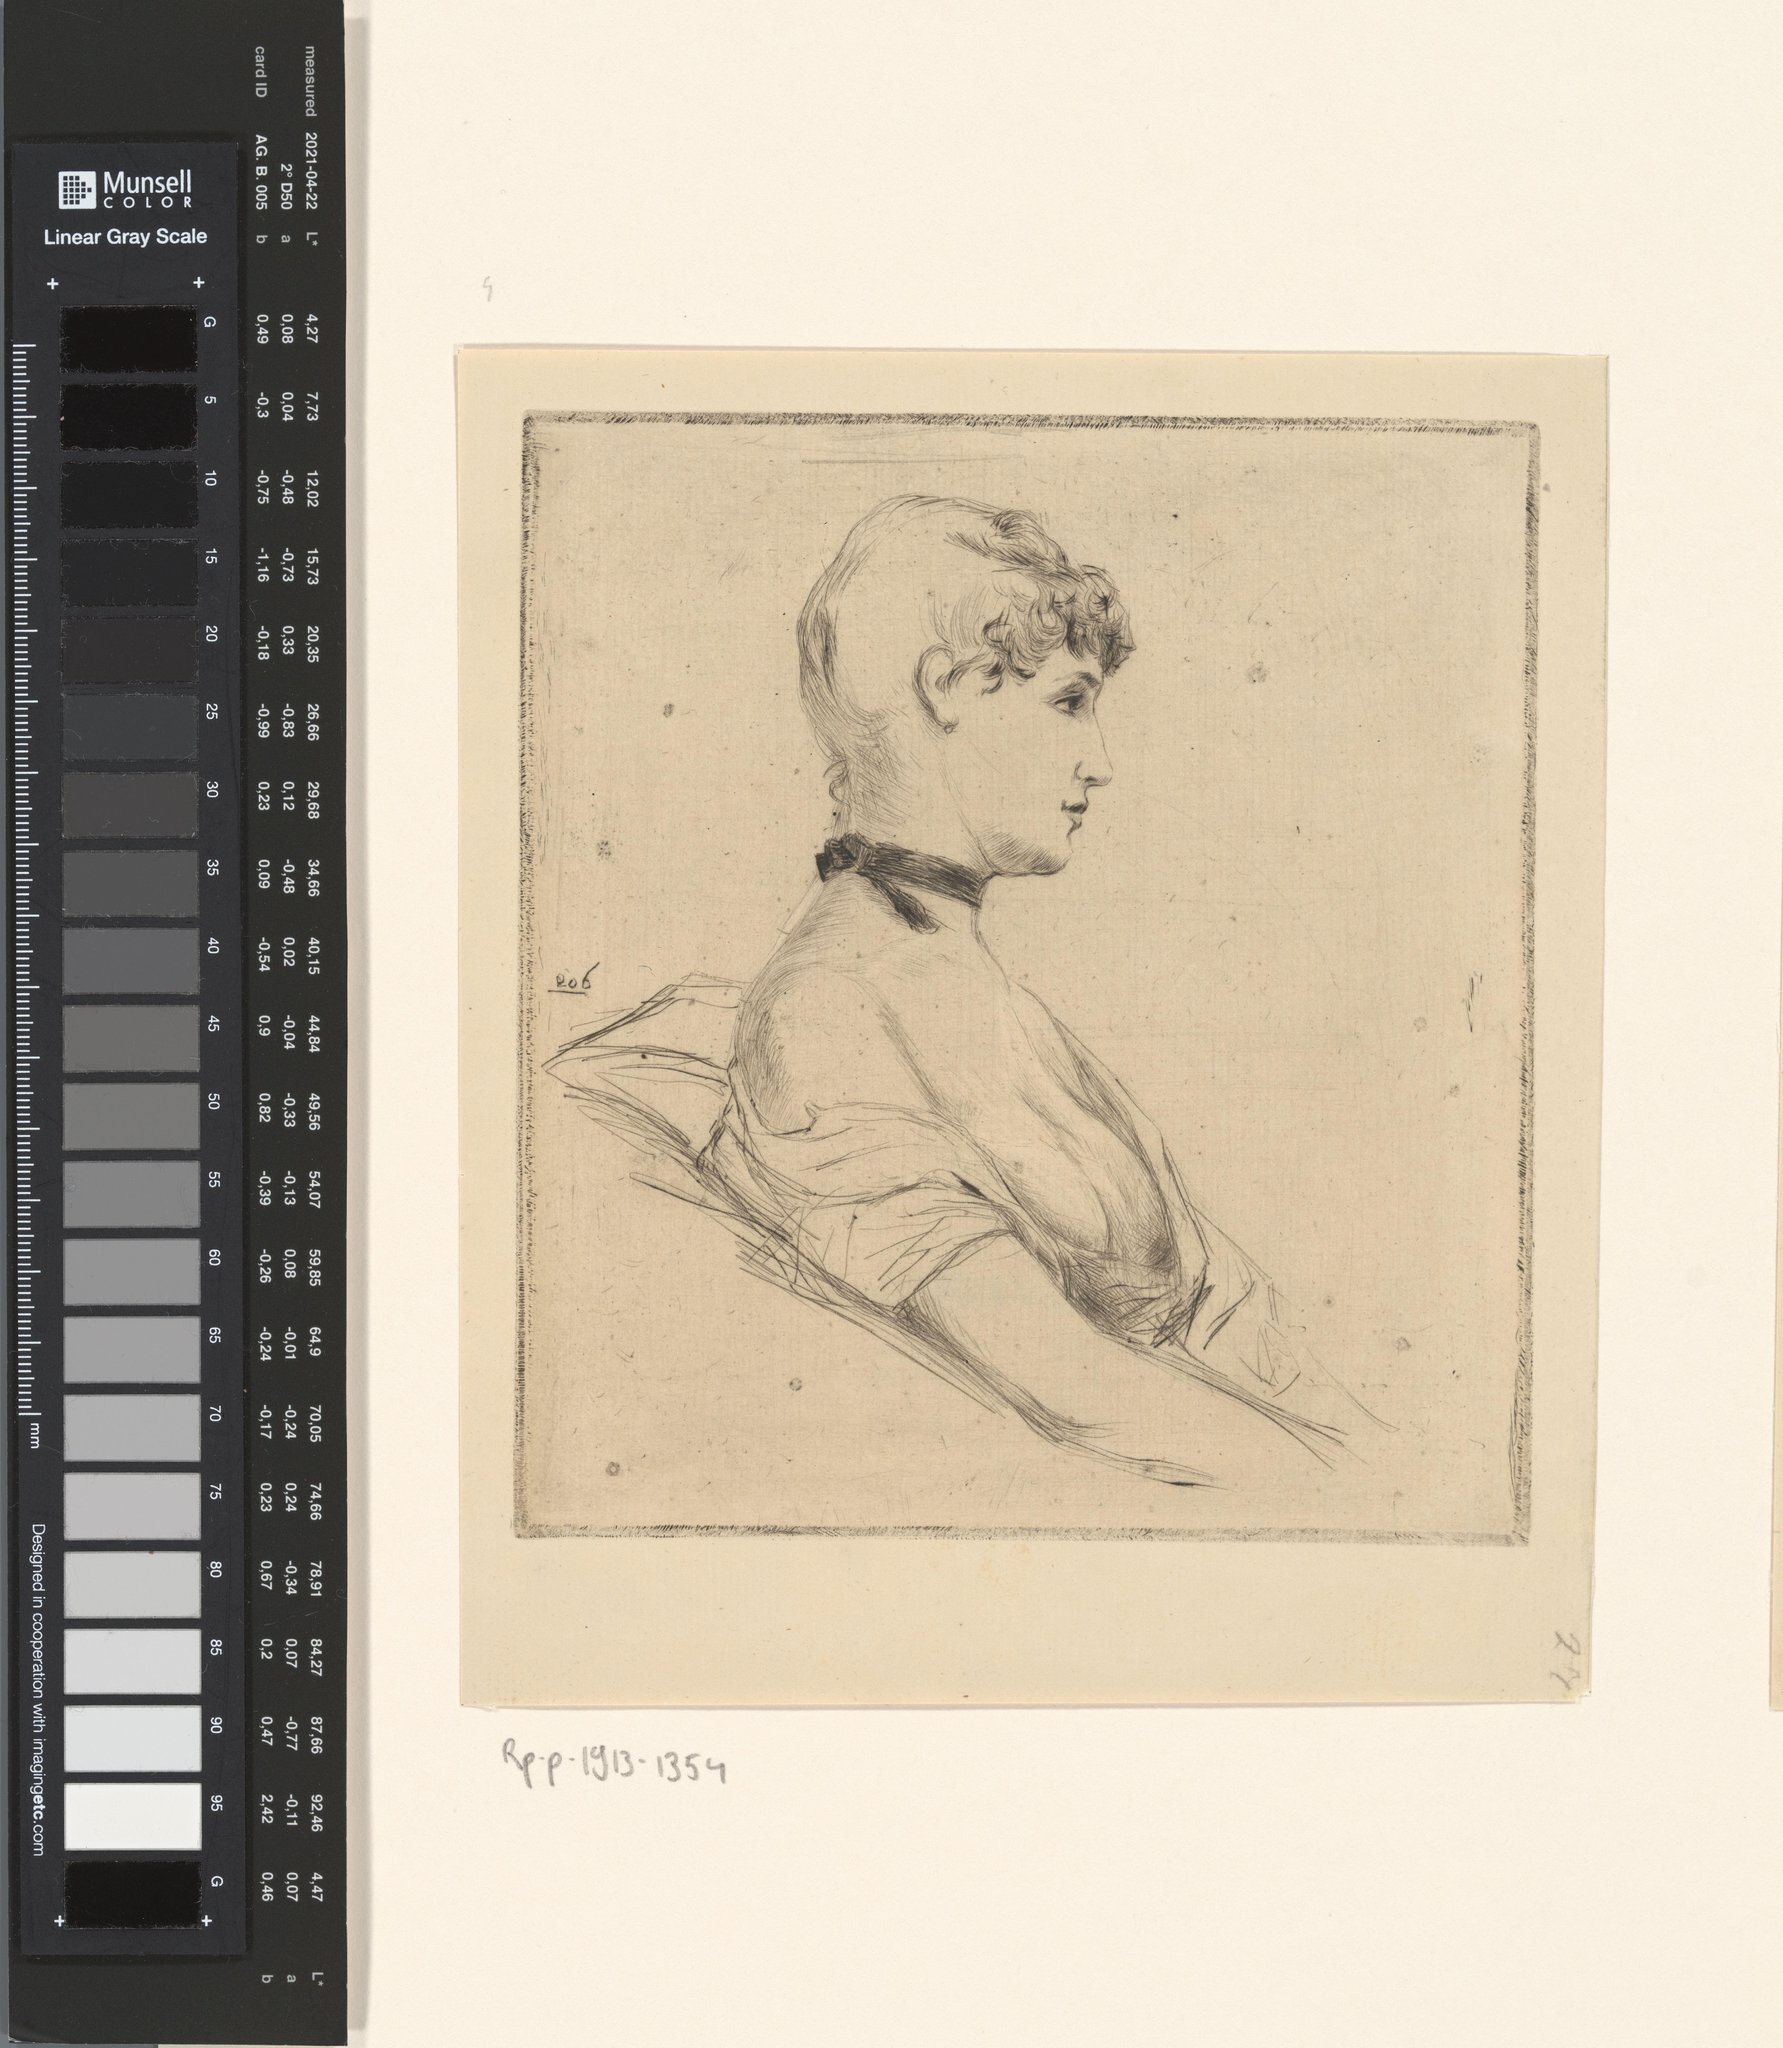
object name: print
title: Riki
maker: philip zilcken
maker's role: draughtsman, painter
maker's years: 1857-1930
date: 1890-1913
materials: paper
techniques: drypoint, intaglio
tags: adolescent, young woman, maiden, historical persons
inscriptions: collector's mark: Lugt 2233